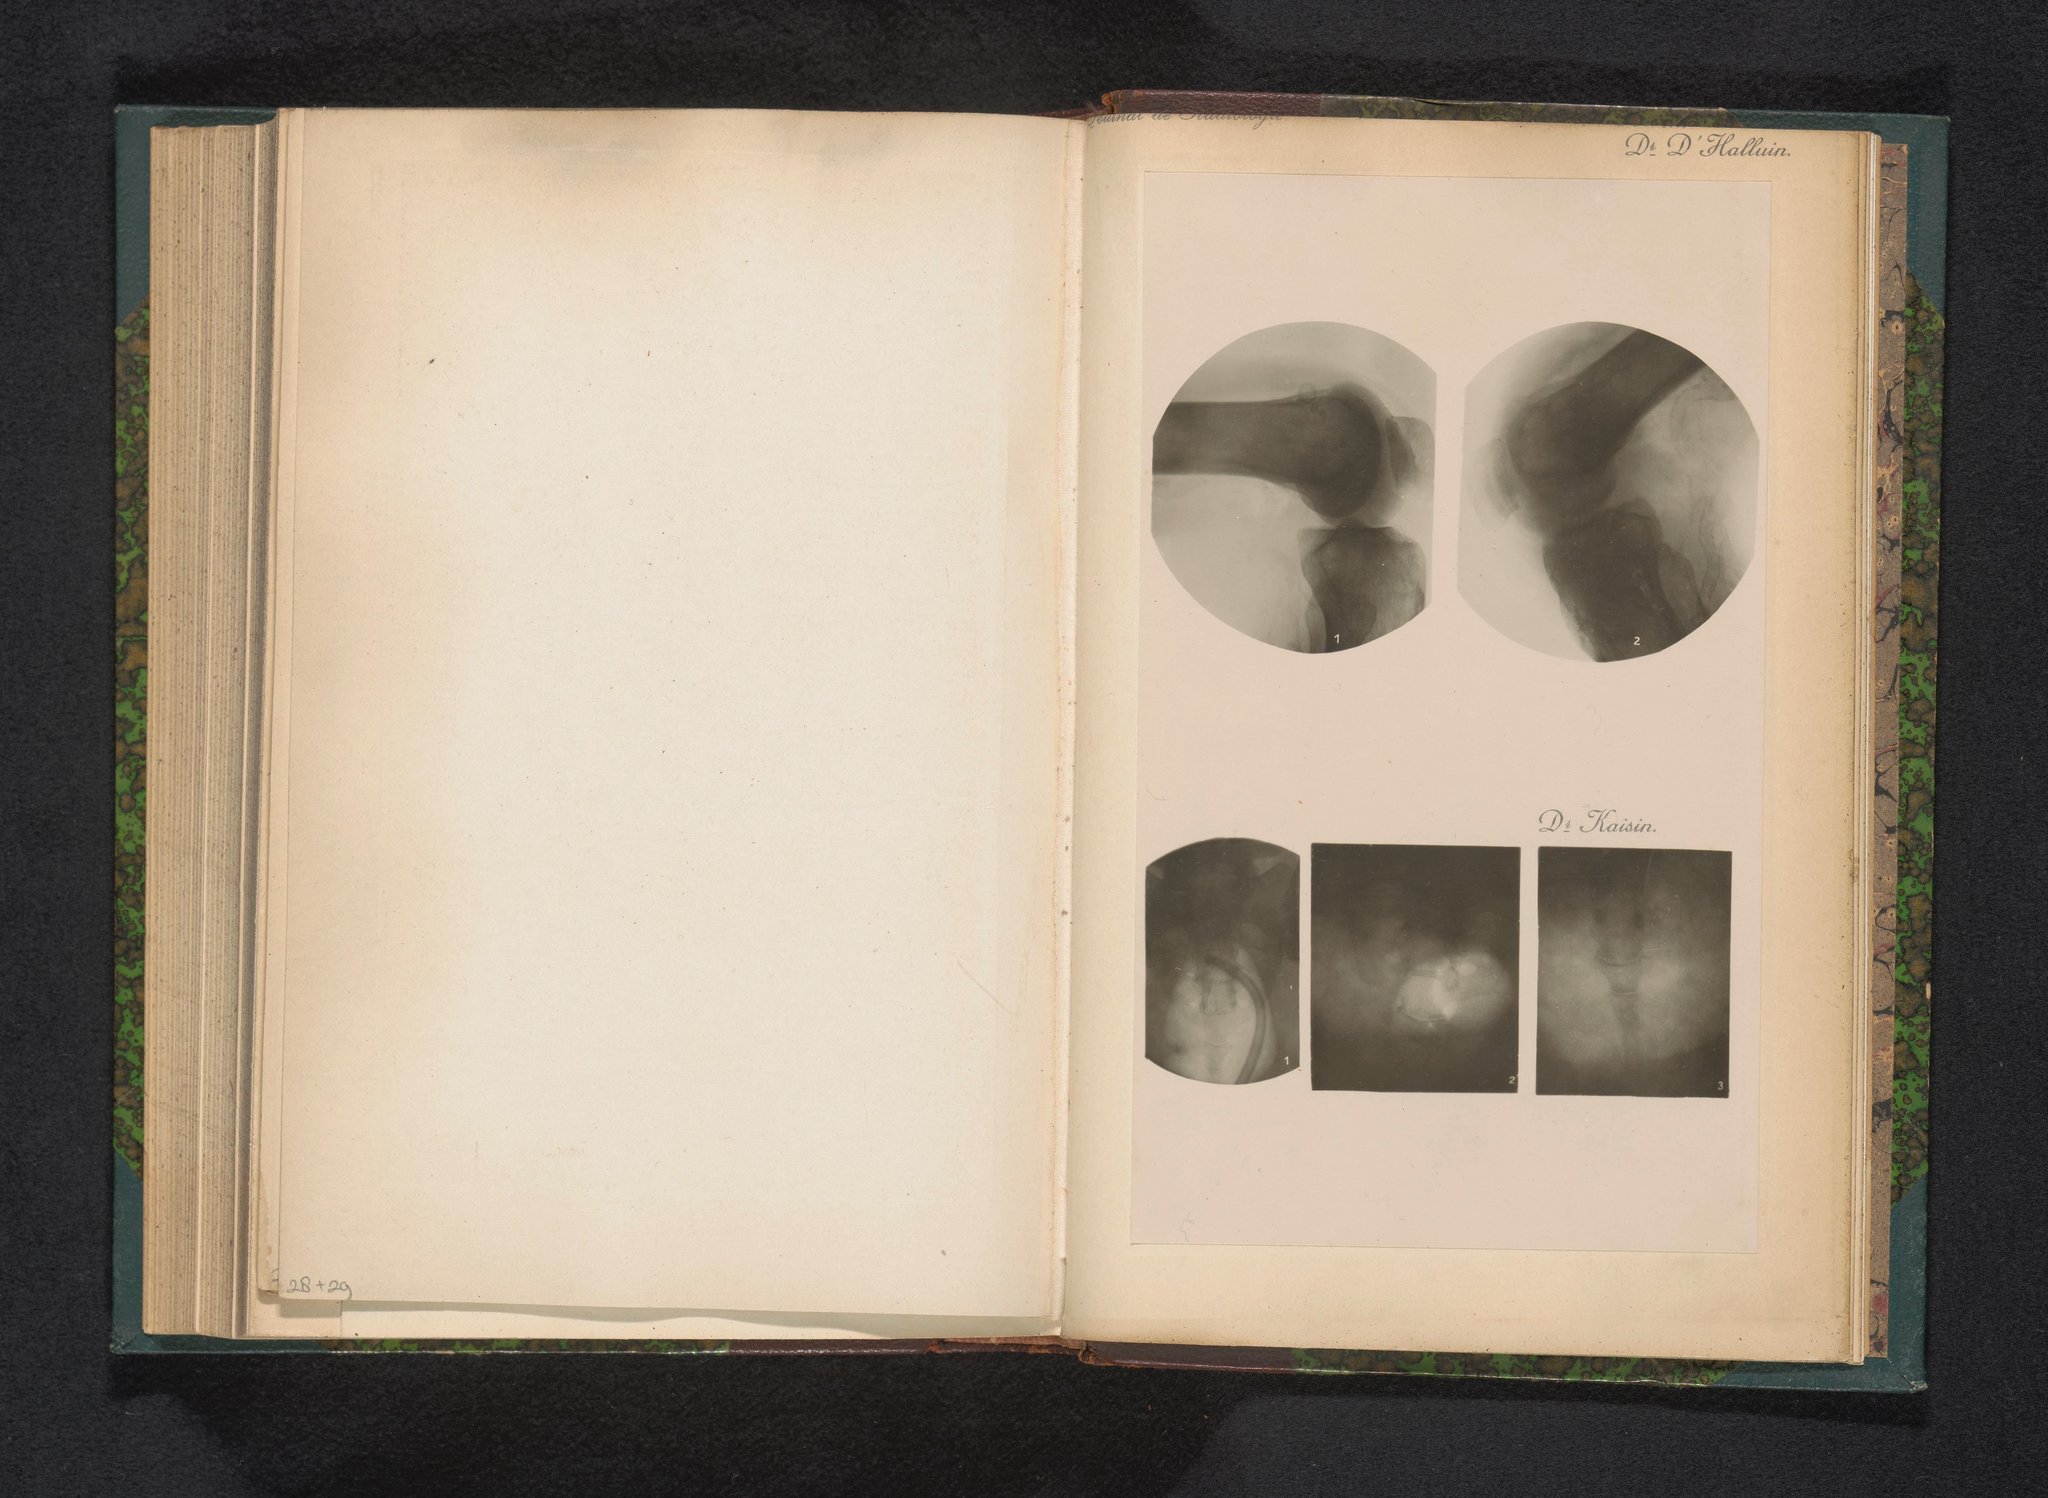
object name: photograph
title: Drie röntgenfoto's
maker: Anonymous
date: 1904-1909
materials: photographic support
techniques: gelatin silver print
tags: x-ray examination, (human) skeleton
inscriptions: name: ‘Dr. Kaisin.’